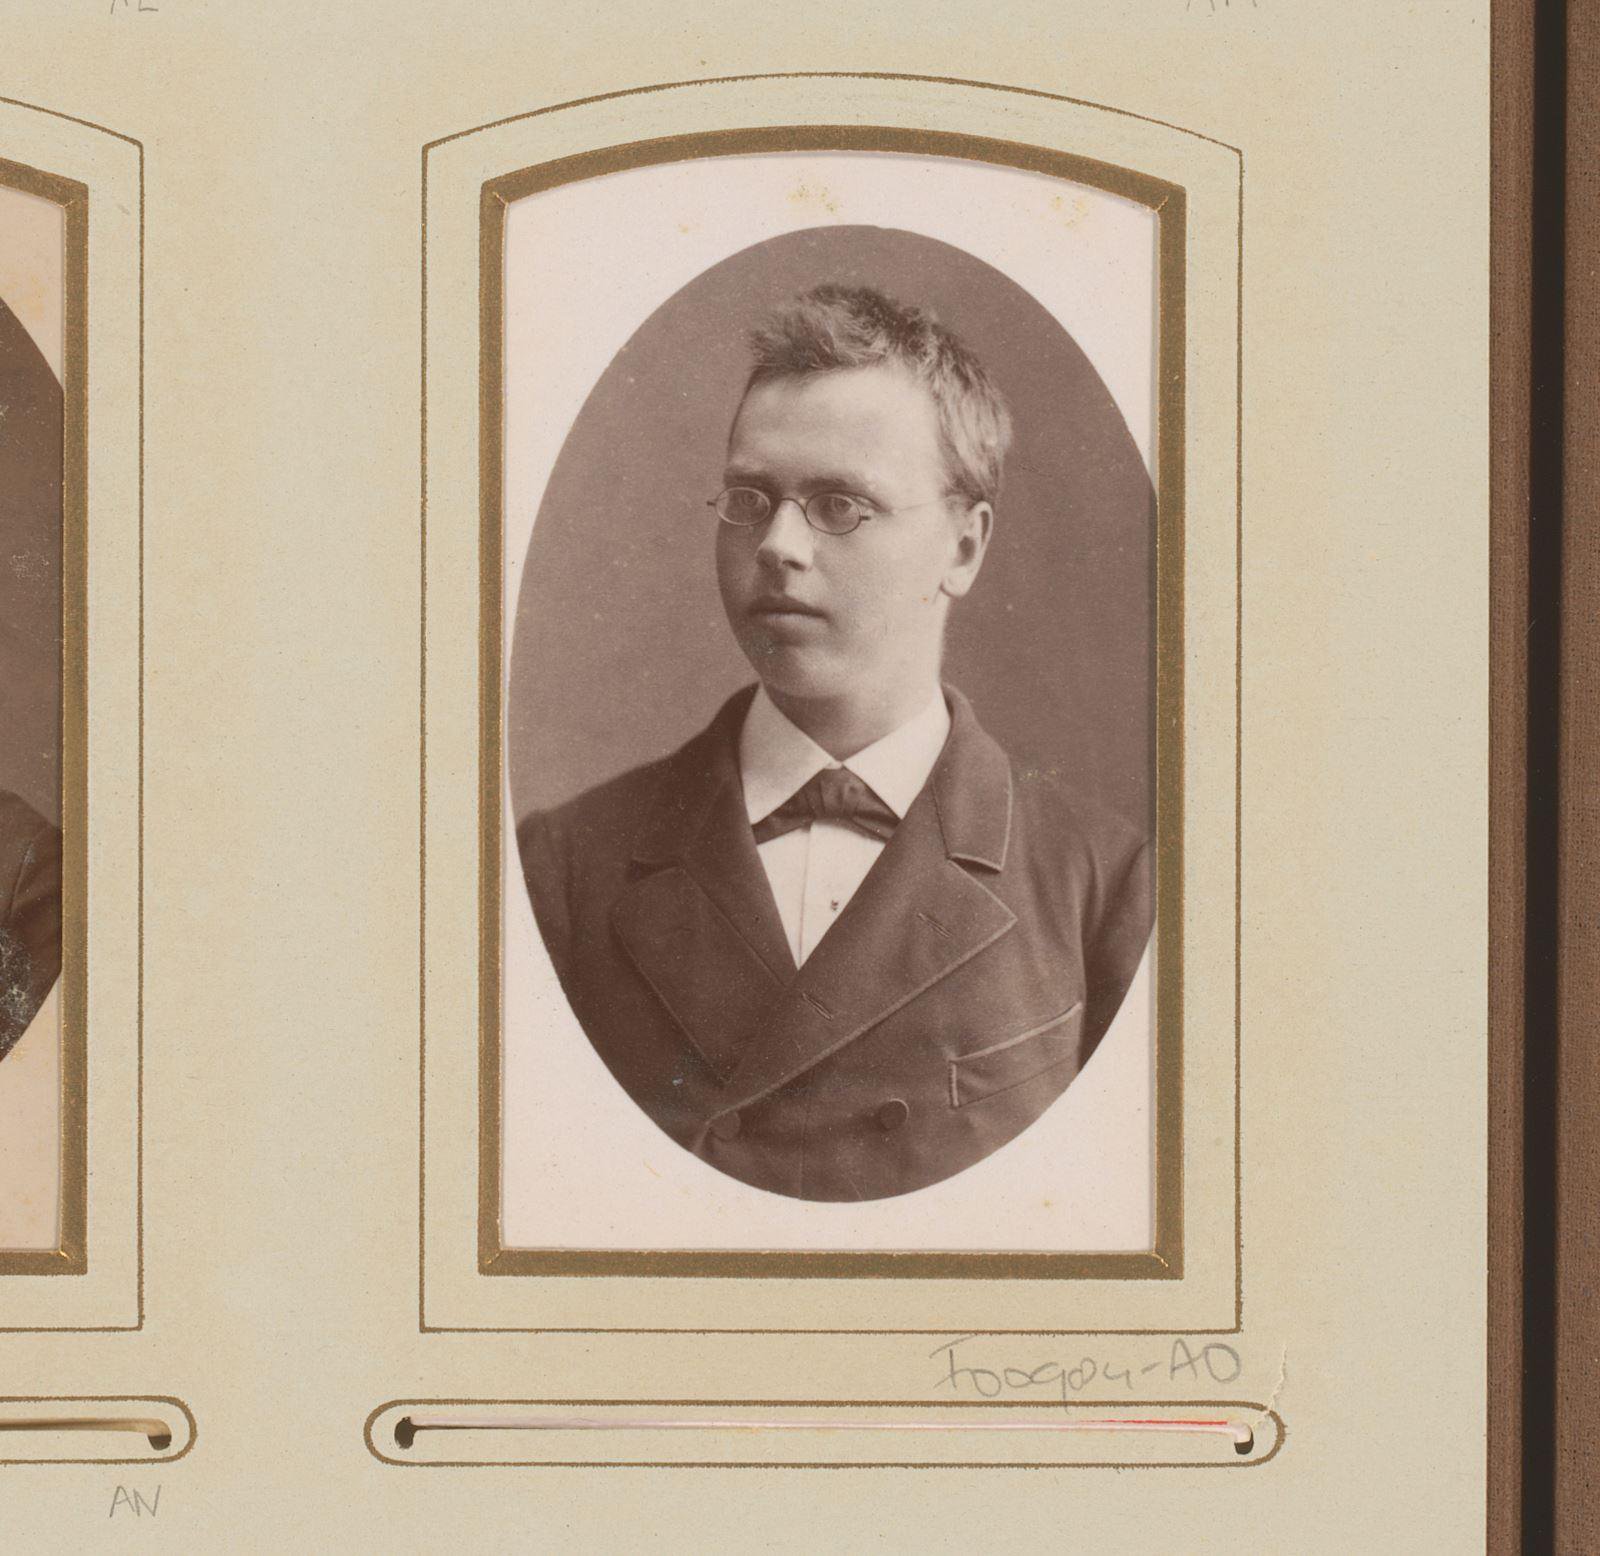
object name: album leaf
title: Portret van een jonge man met bril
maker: friedrich julius von kolkow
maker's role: fotograaf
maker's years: 1839-1914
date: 1879-1900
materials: cardboard, photographic support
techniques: albumen print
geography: groningen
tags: eyeglasses, spectacles, historical persons, youth, adolescent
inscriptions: inscription: ‘1879./ (...)/ Fr. Jul. von Kolkow/ Koninklyk Nederlandsch Hof-Photograph/ GRONINGEN.’